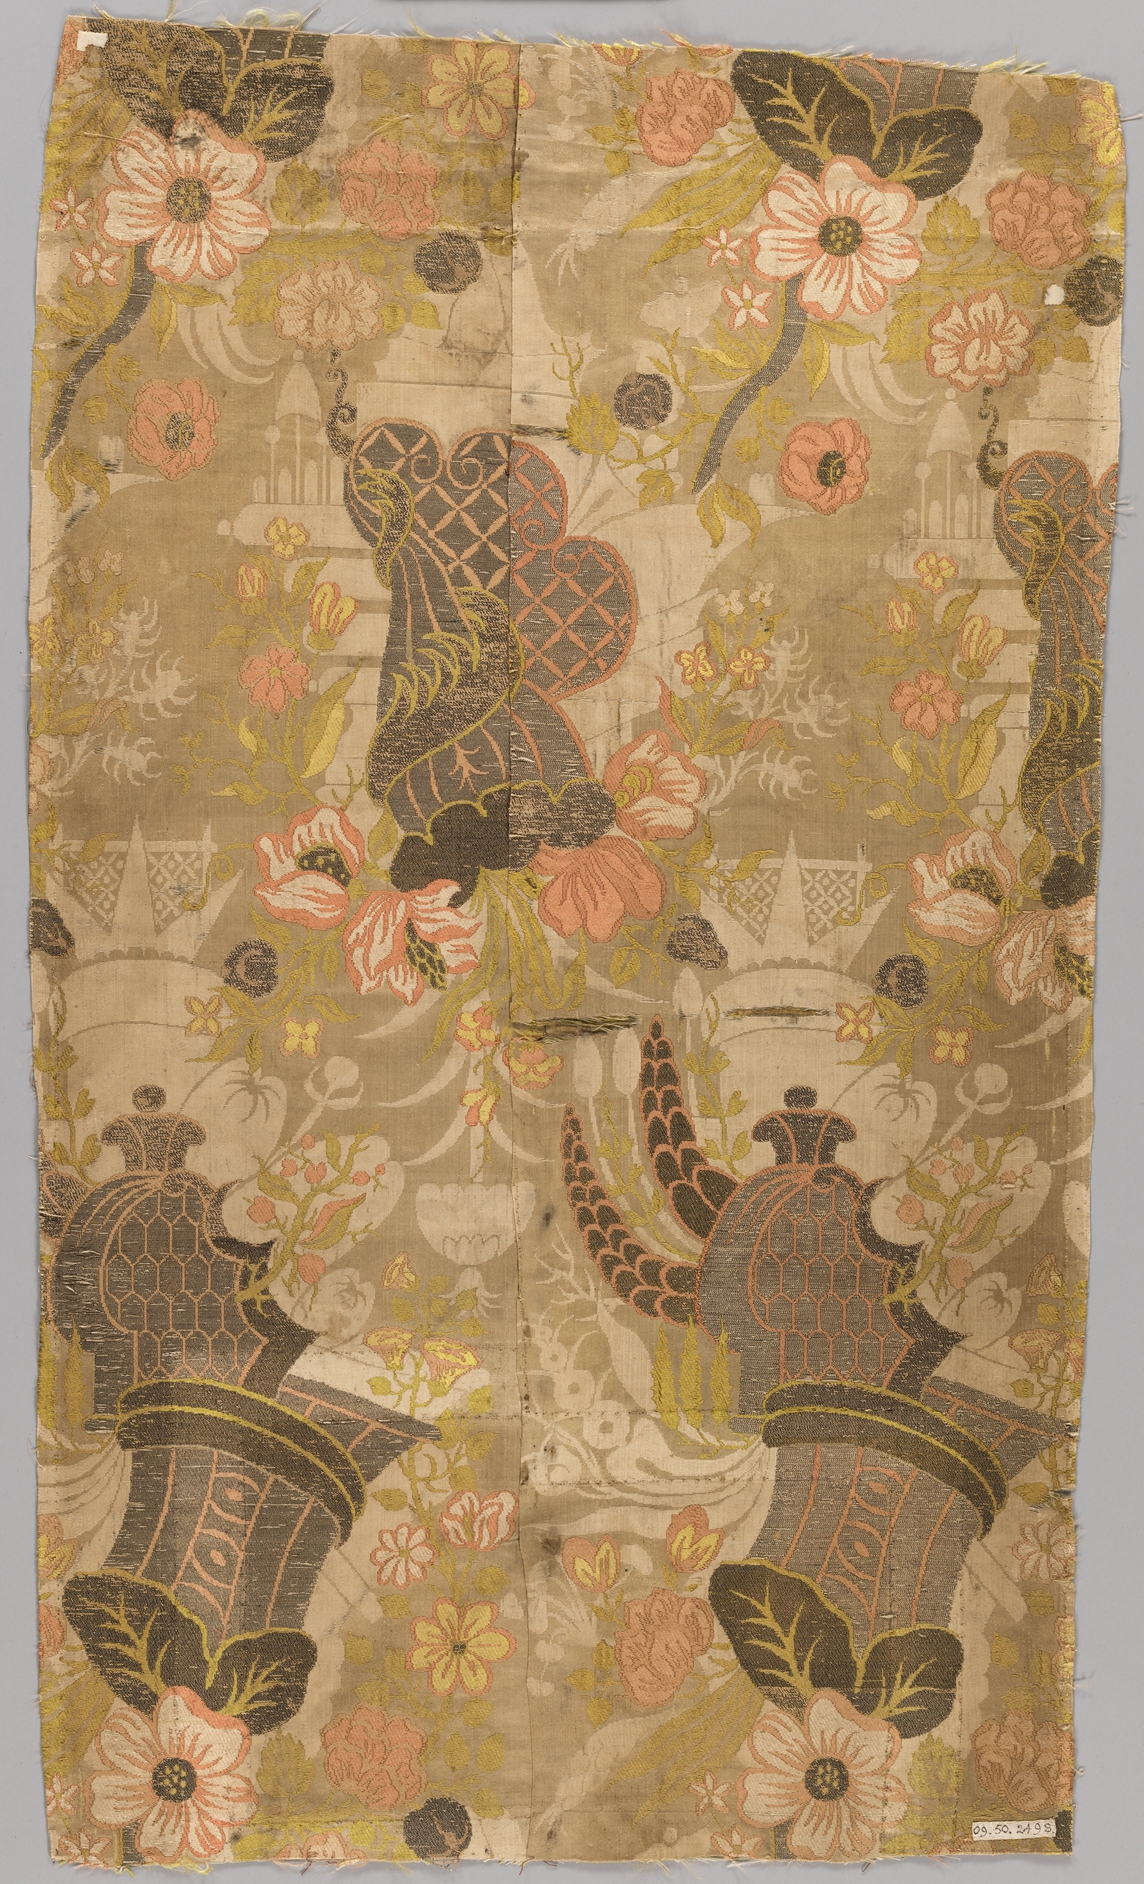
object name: piece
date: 1700-1710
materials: metal thread, silk